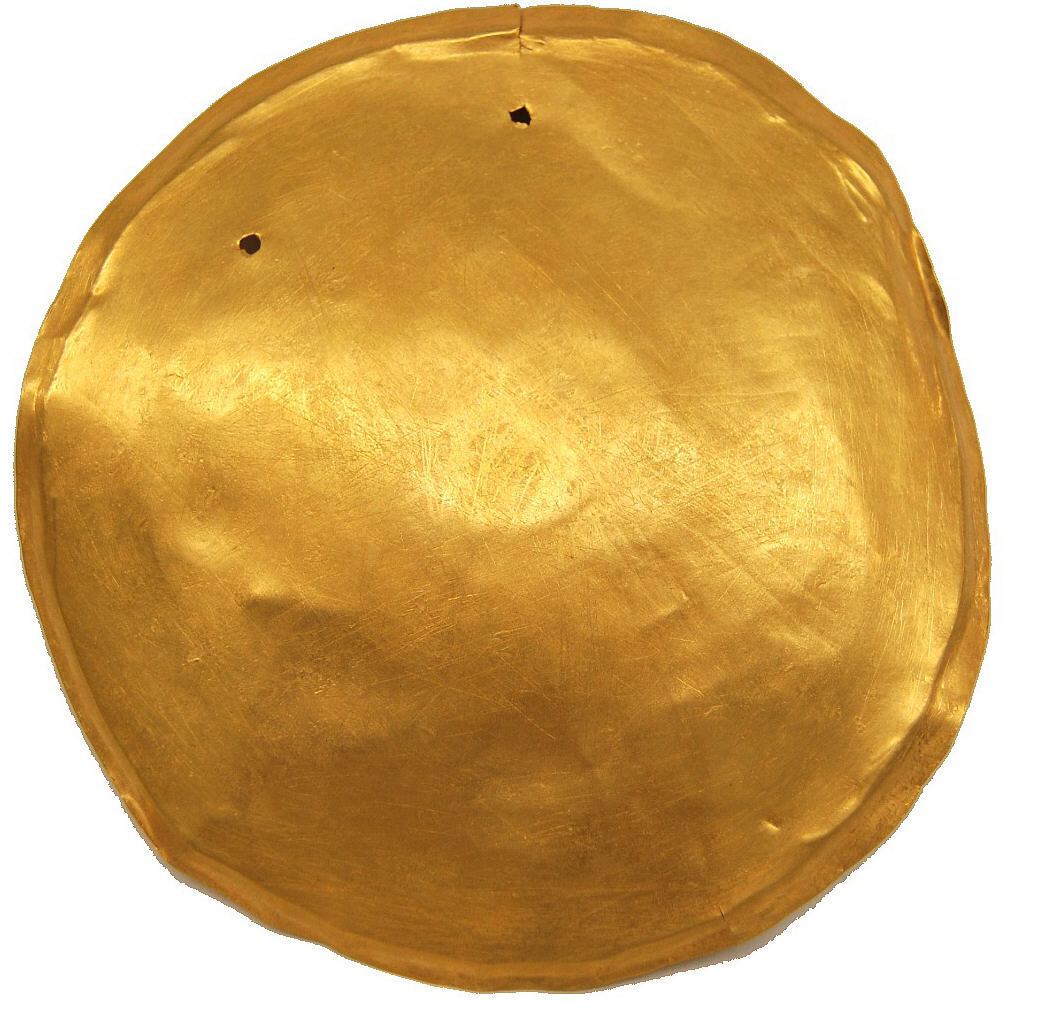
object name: pectoral disk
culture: colombian or panamanian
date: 701-1600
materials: gold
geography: colombia